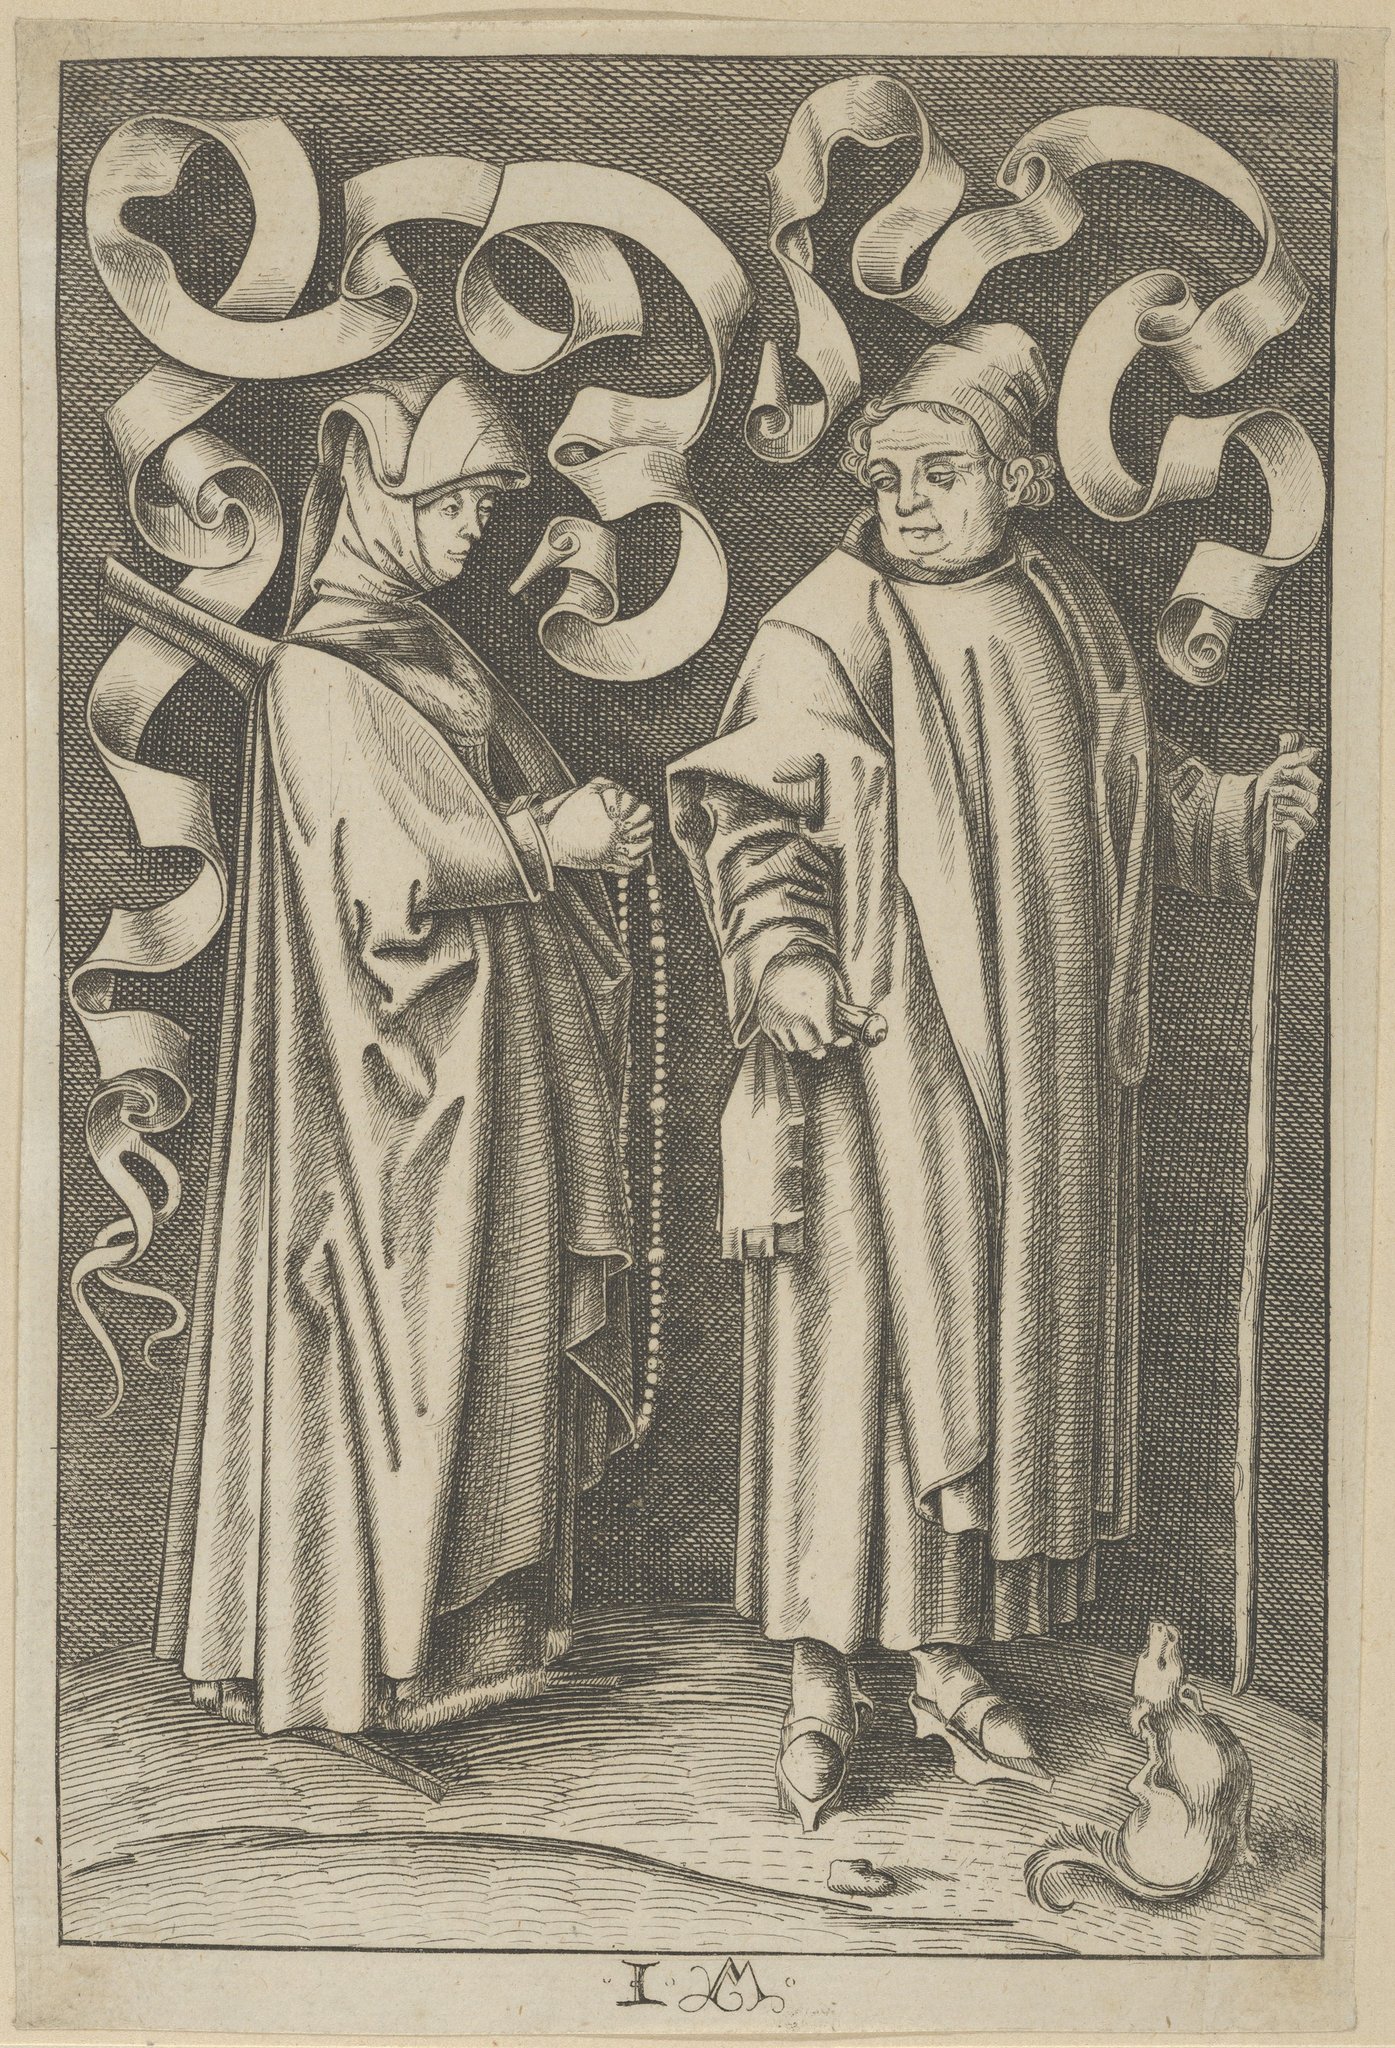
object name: print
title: The Churchgoers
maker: Anonymous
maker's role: artist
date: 1495-1550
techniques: engraving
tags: animals,beads,women